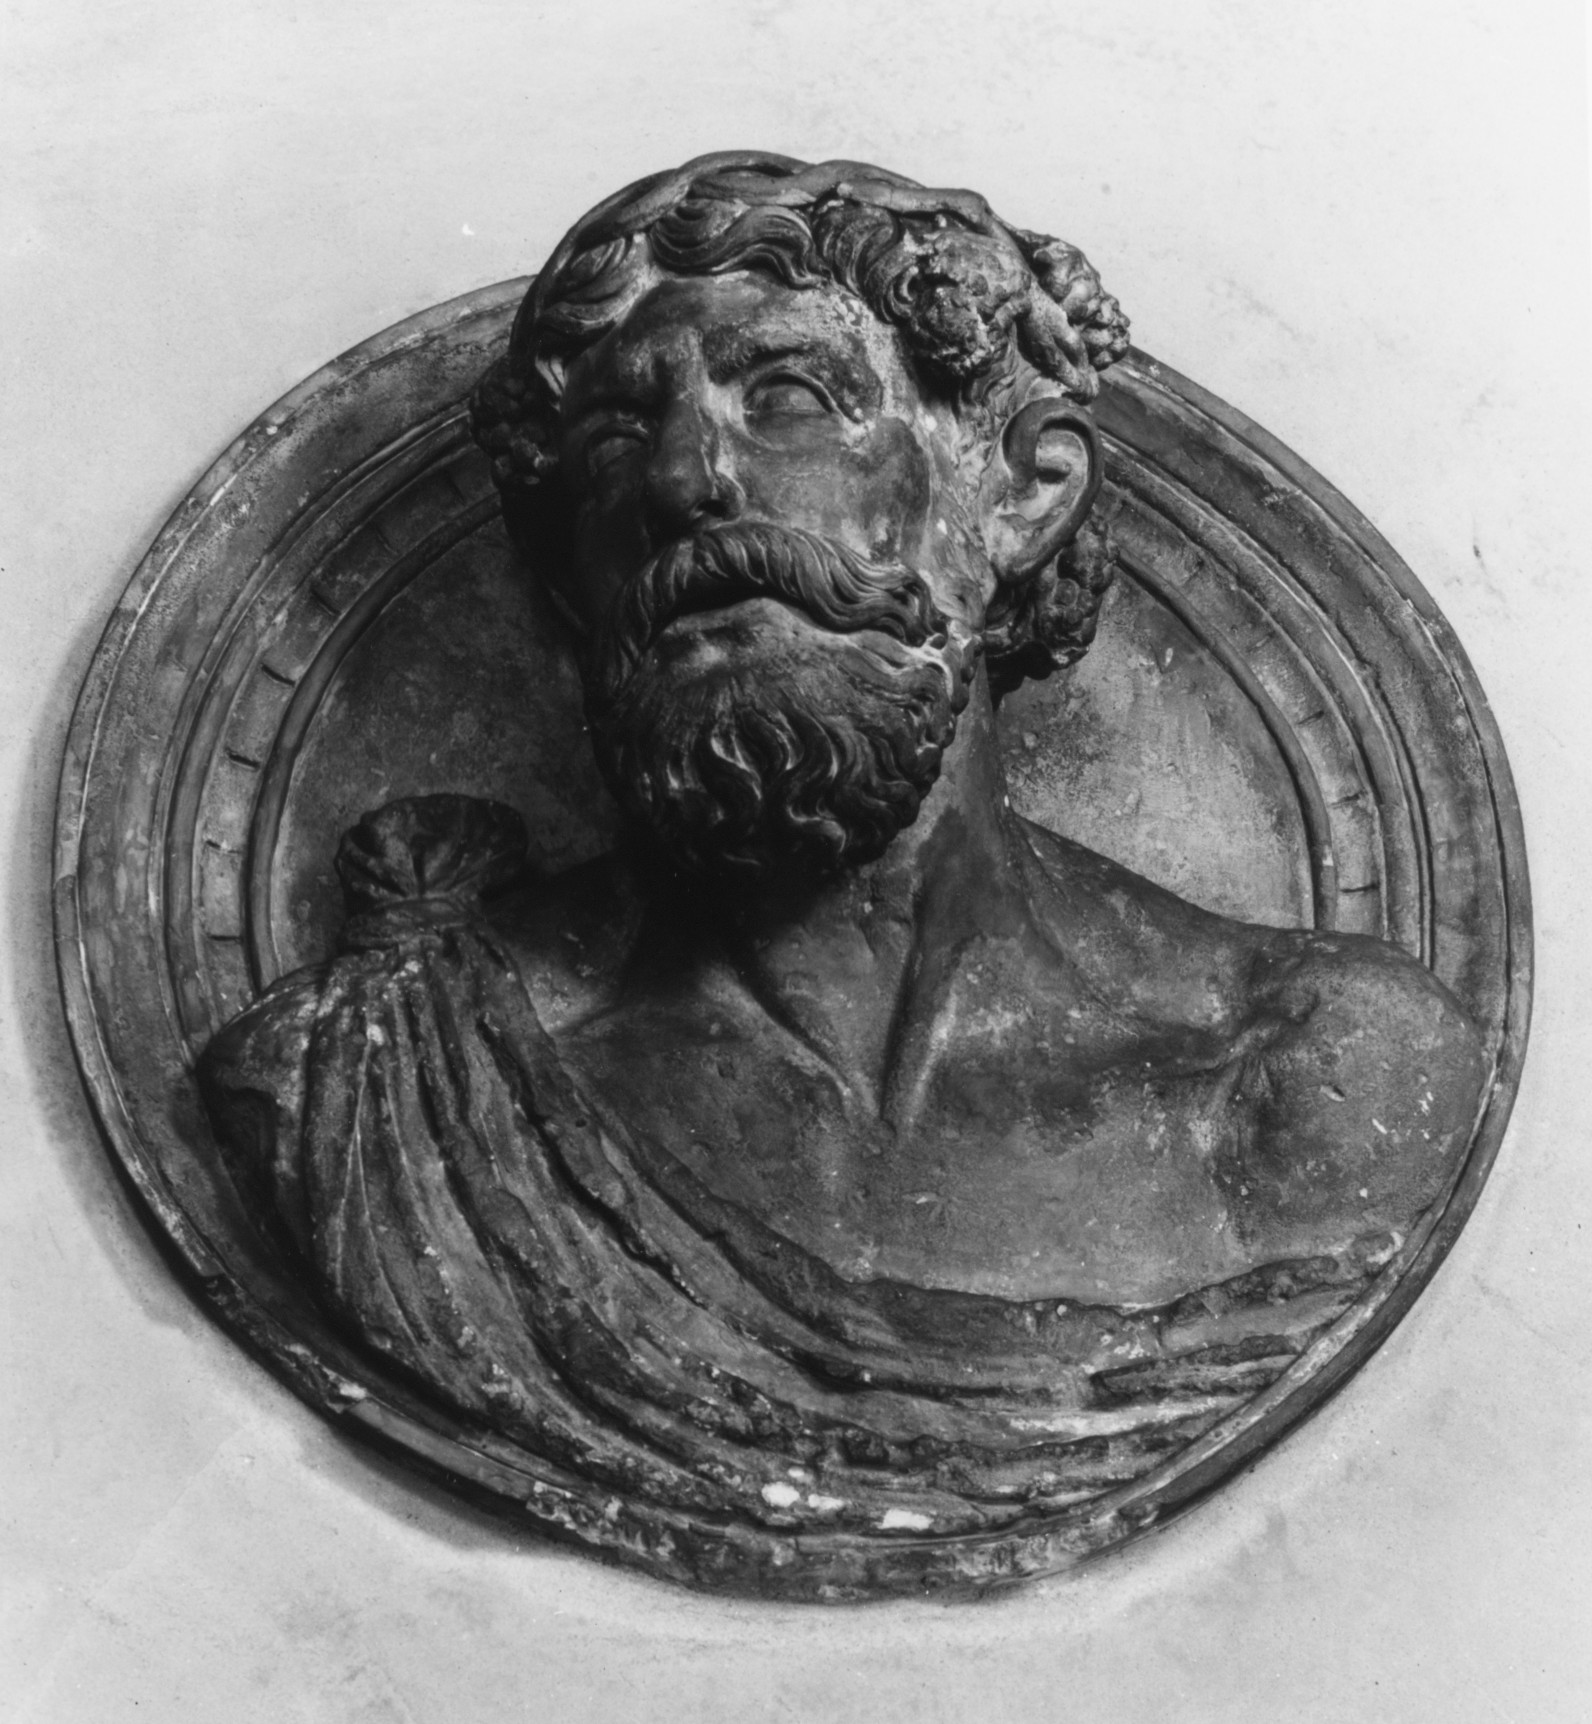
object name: roundel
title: Bust of a wild man or rustic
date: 1525-1530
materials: limestone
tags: men,portraits